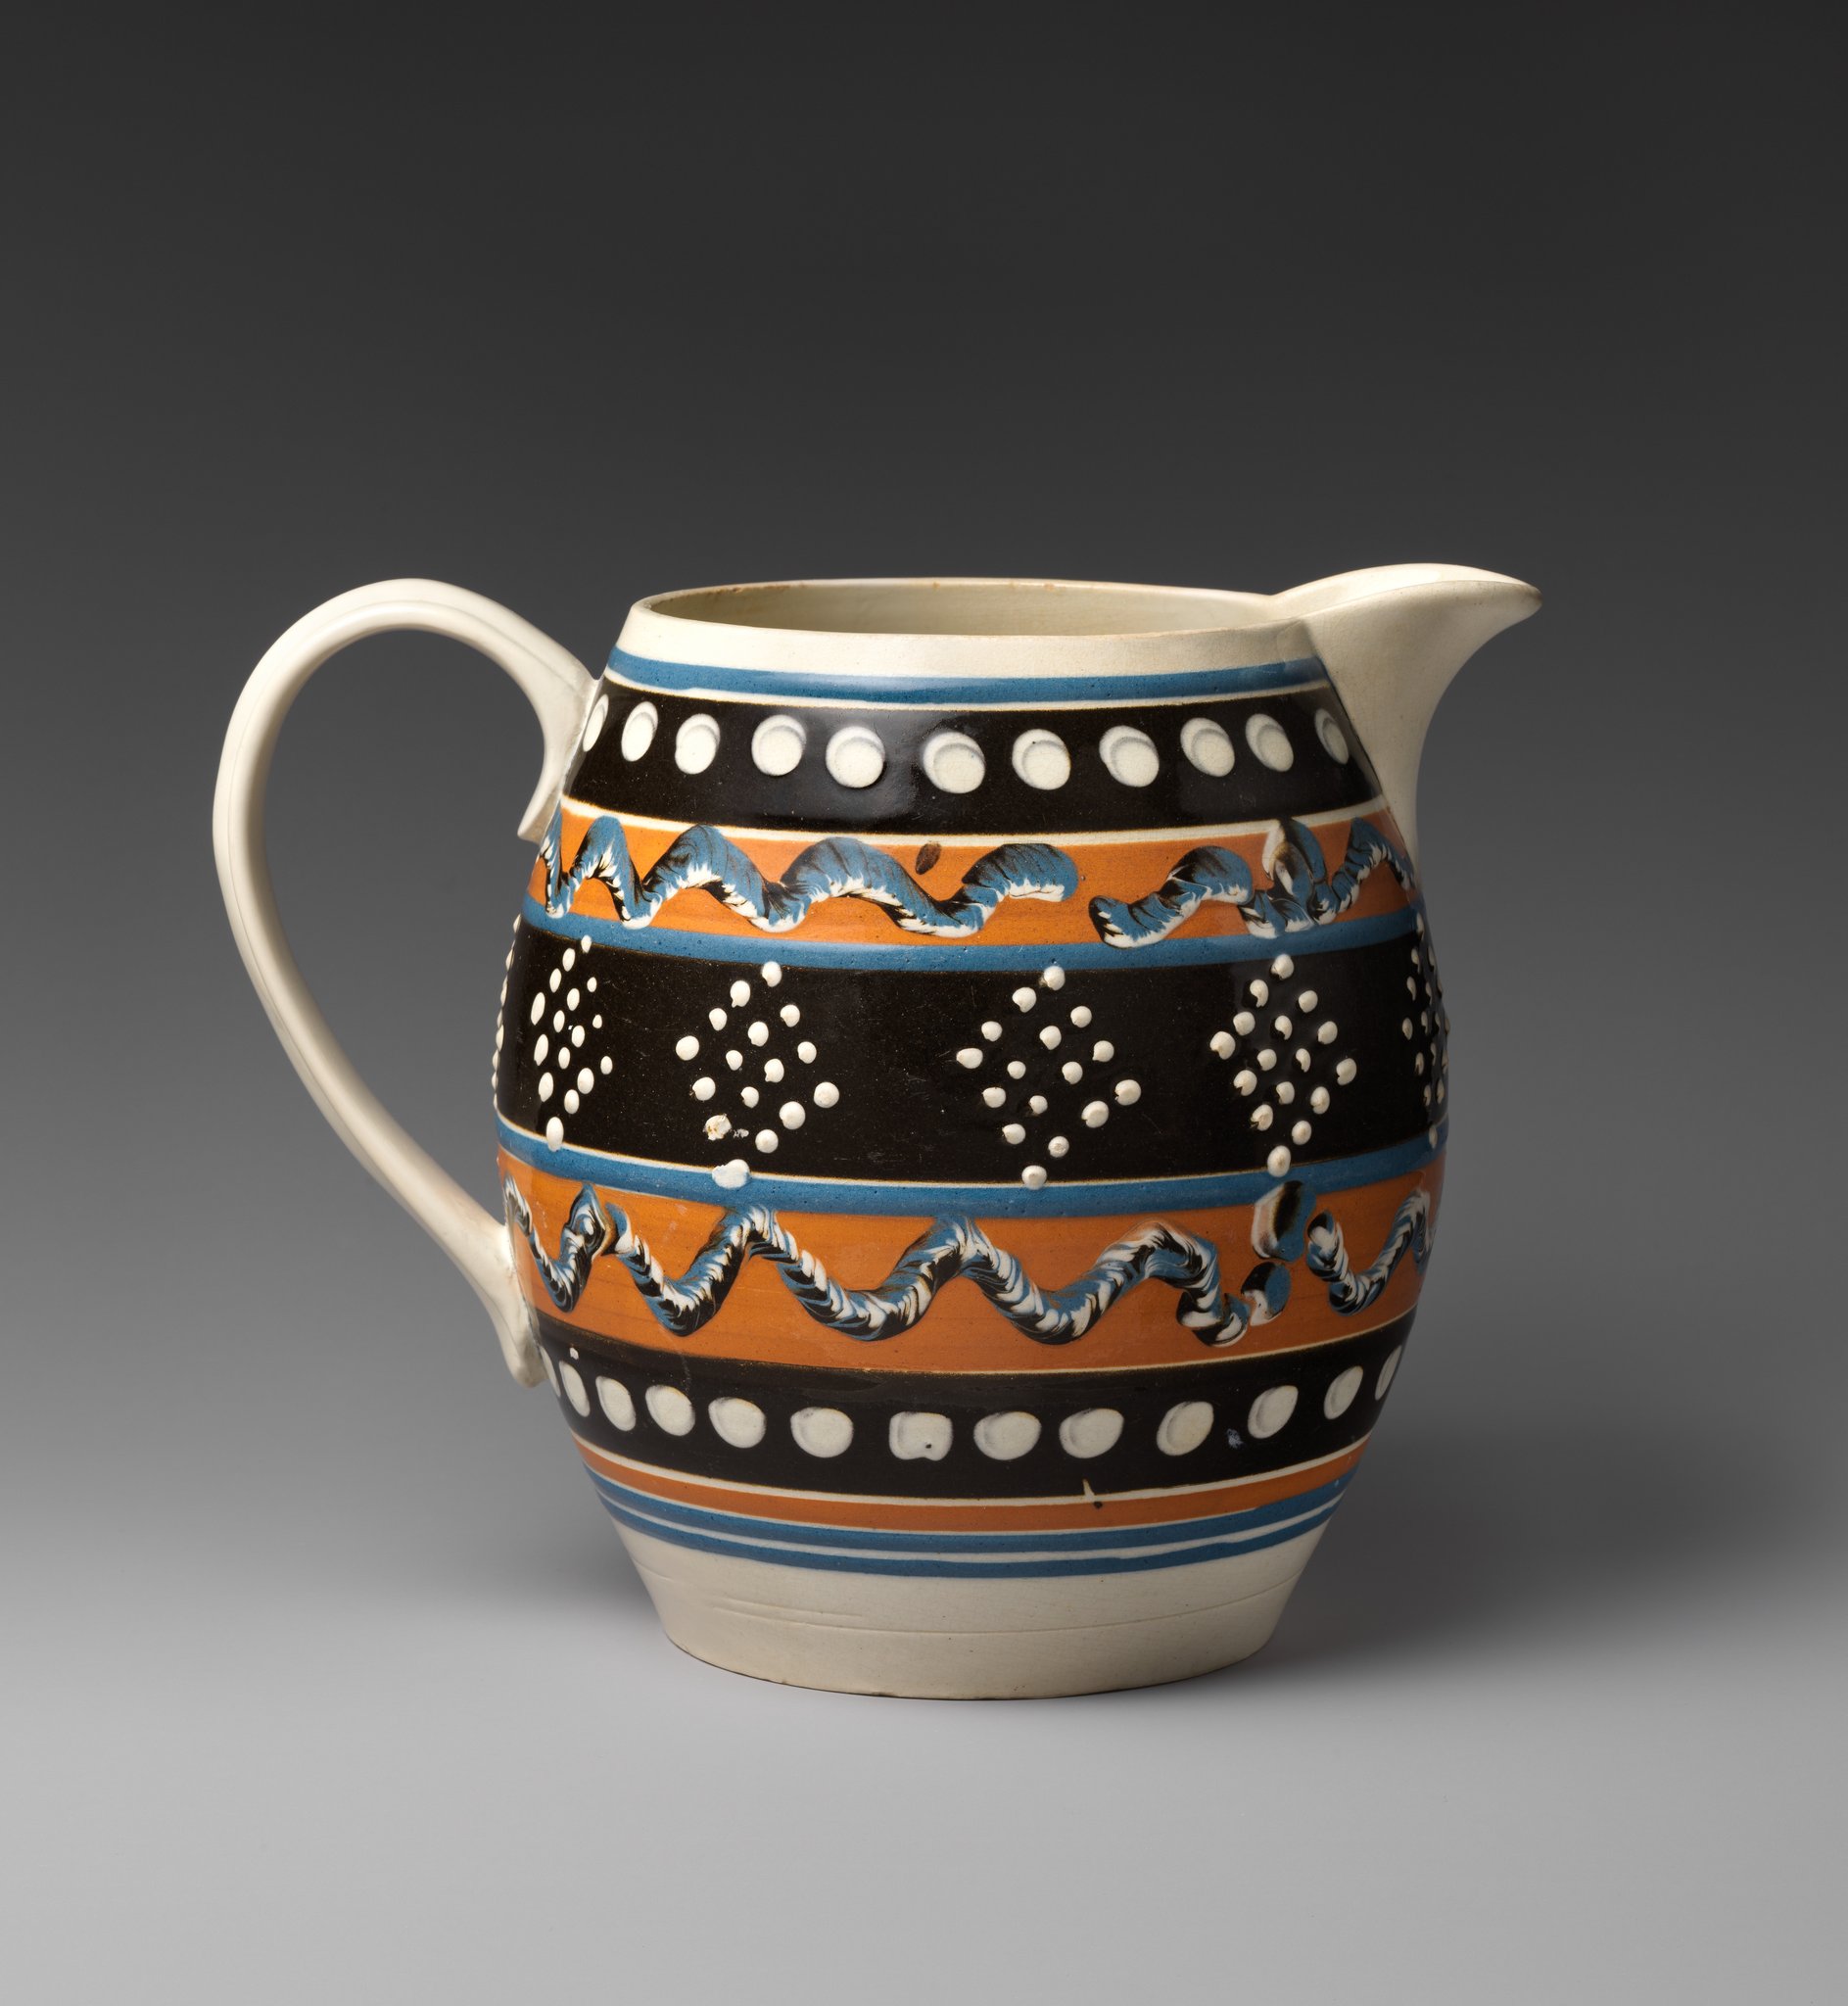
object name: jug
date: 1820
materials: earthenware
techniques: glazing